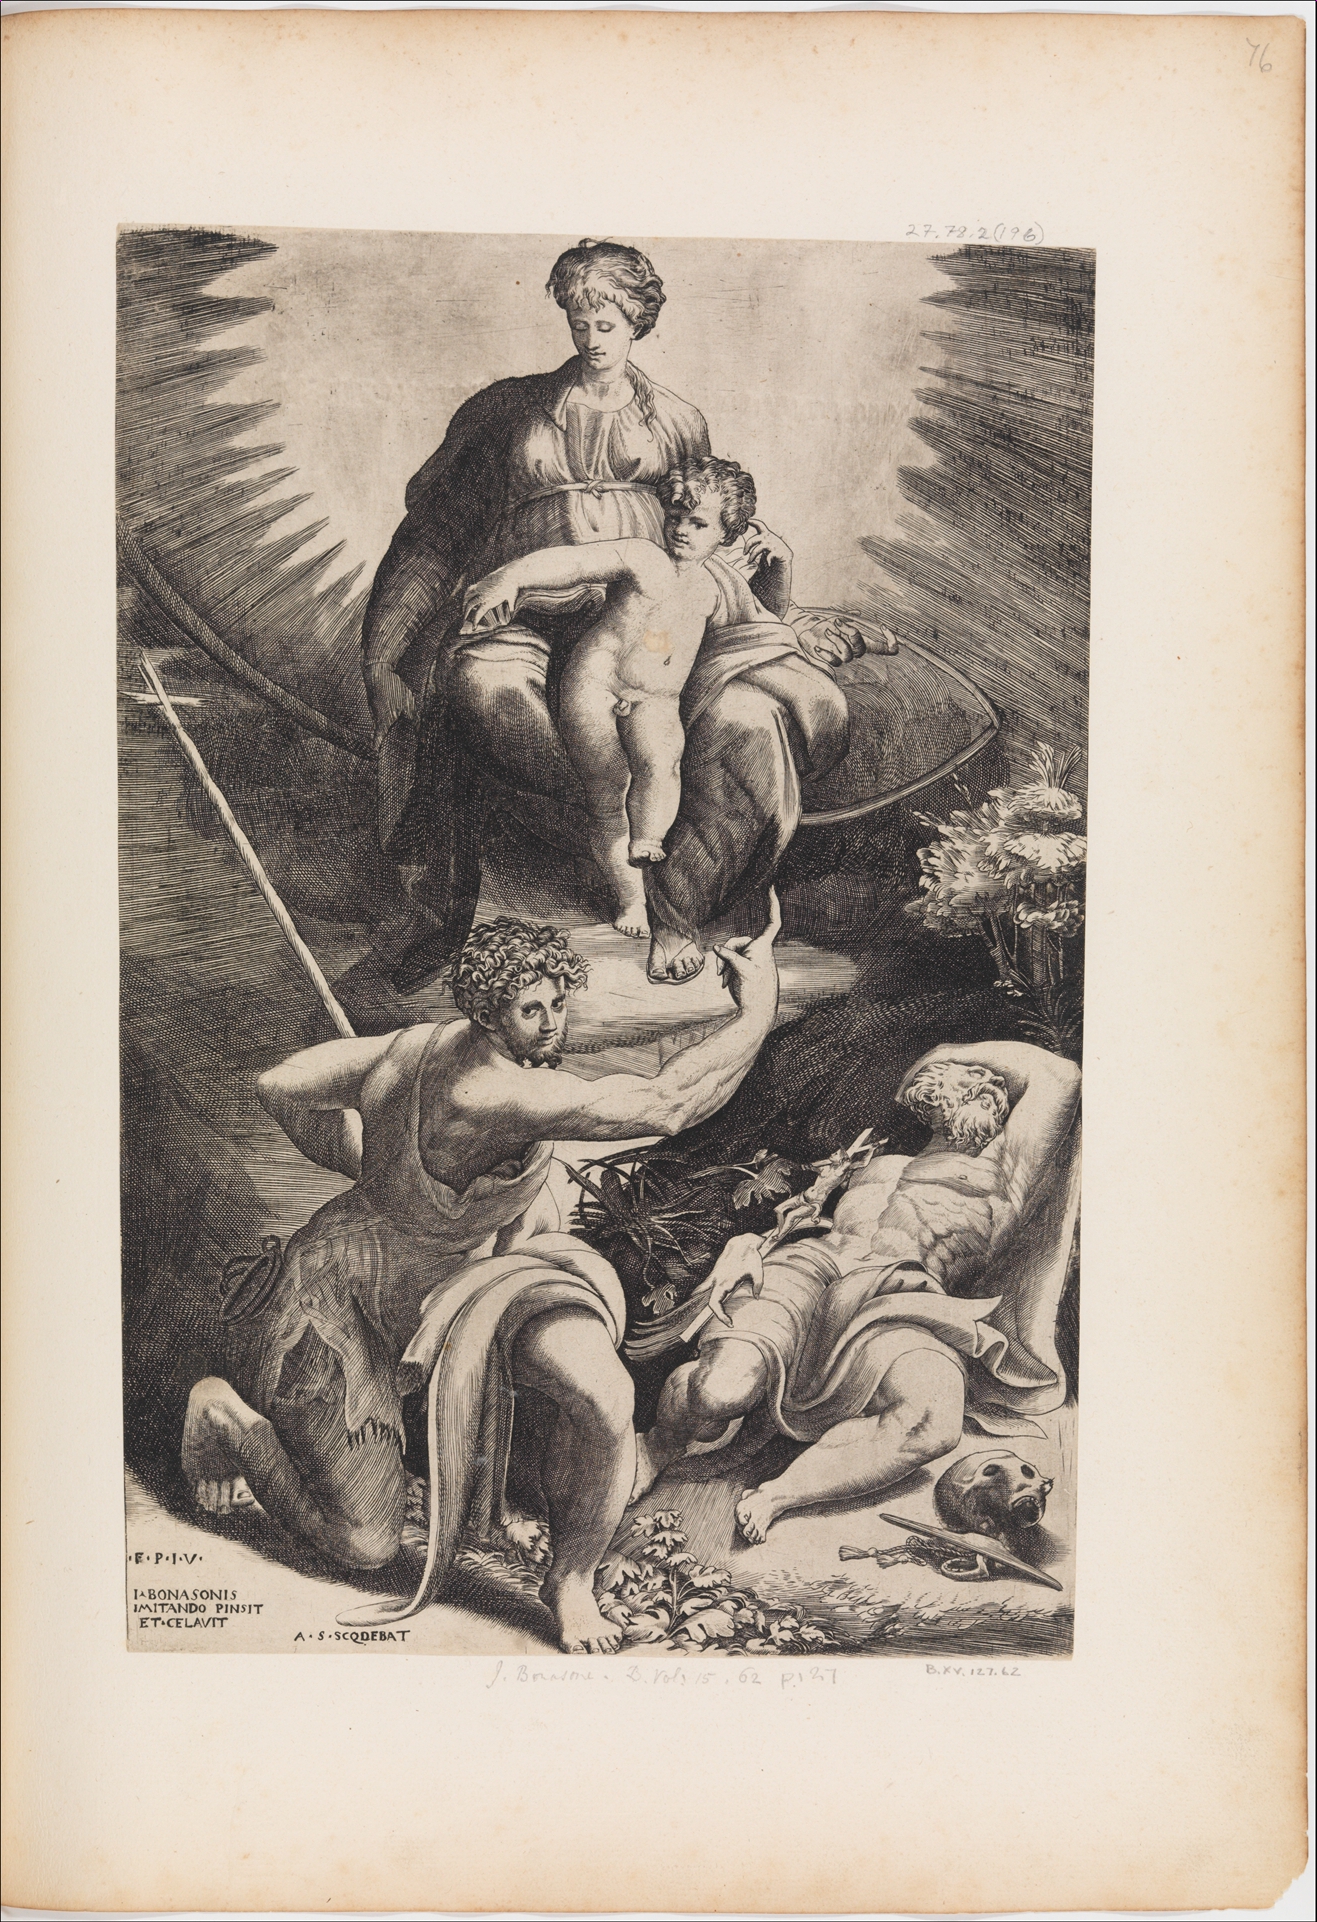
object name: print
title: The Vision of St. Jerome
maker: giulio bonasone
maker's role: artist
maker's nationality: italian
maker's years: 1510-1576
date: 1510-1576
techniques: engraving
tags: men,madonna and child,saint jerome,cross